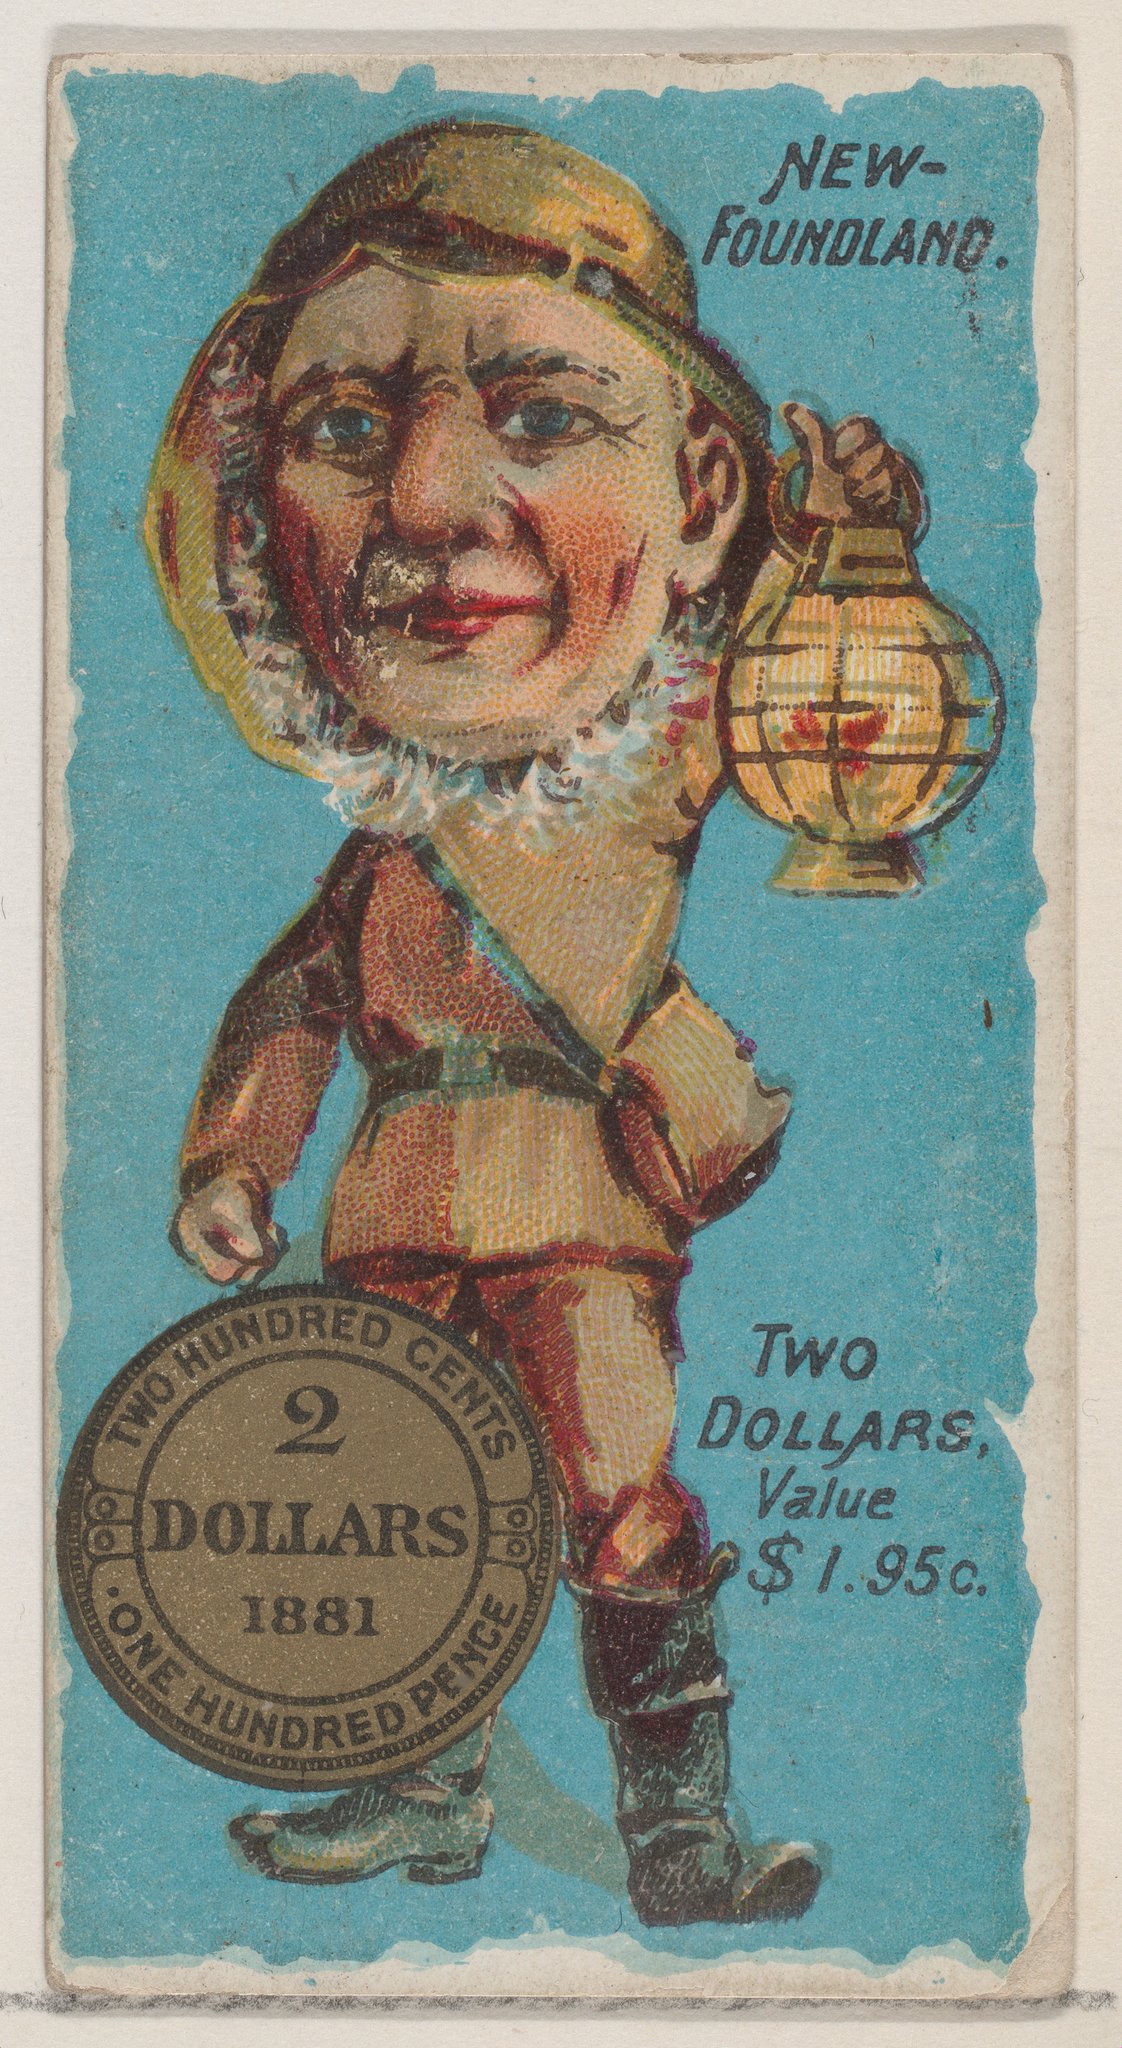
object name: print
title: Newfoundland, Two Dollars, from the series Coins of All Nations (N72, variation 2) for Duke brand cigarettes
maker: w. duke, sons & co.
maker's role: publisher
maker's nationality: american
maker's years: 1870-1920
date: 1889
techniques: color lithograph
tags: men,coins